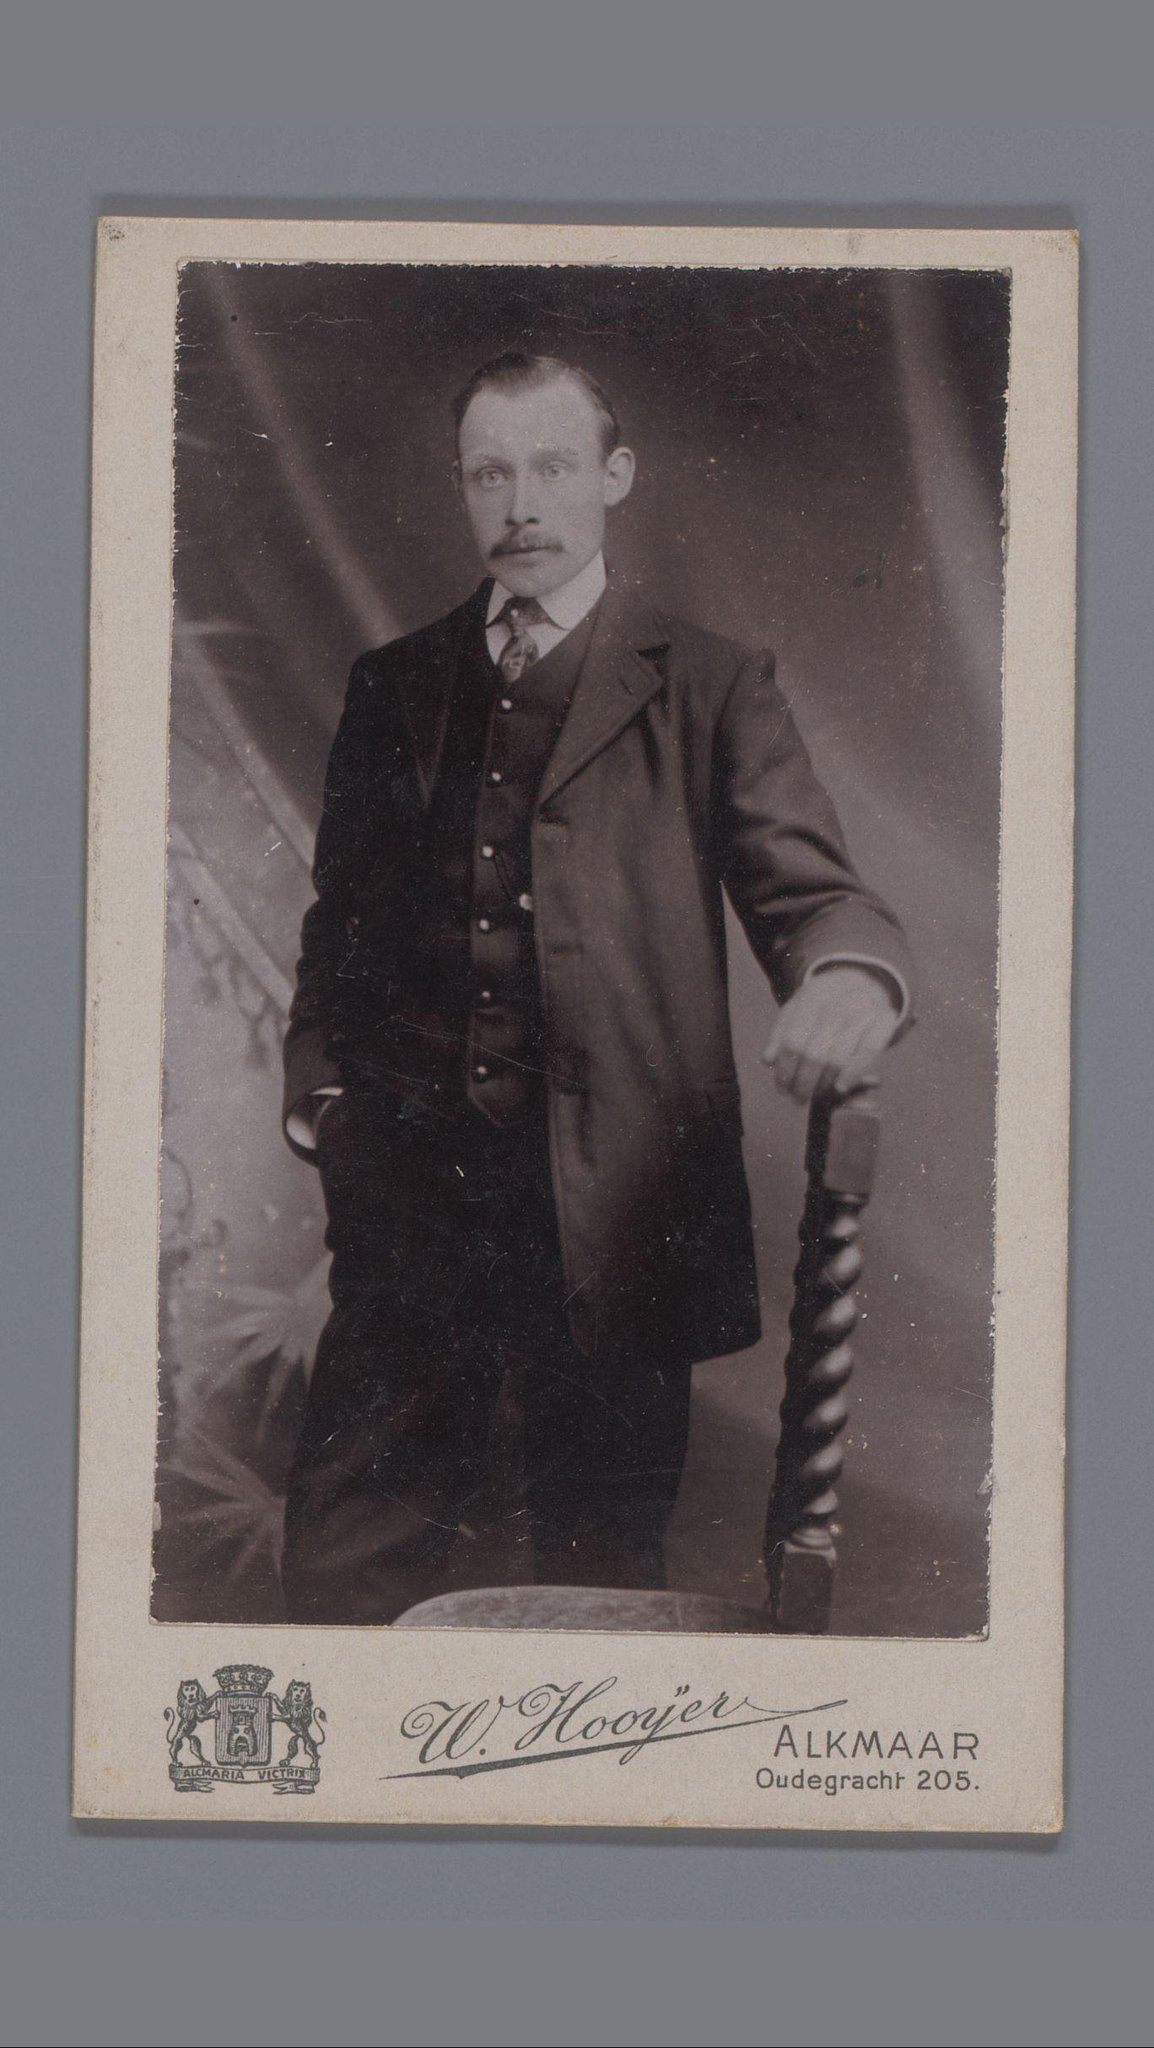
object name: carte de visite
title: Portret van een onbekende man, staande naast een stoel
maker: willem hooijer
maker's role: fotograaf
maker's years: 1855-1939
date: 1903-1909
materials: cardboard, photographic support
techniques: gelatin silver print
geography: alkmaar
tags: adult man, historical persons, chair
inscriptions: address: ‘W. Hooijer/ ALKMAAR/ Oudegracht 205.’